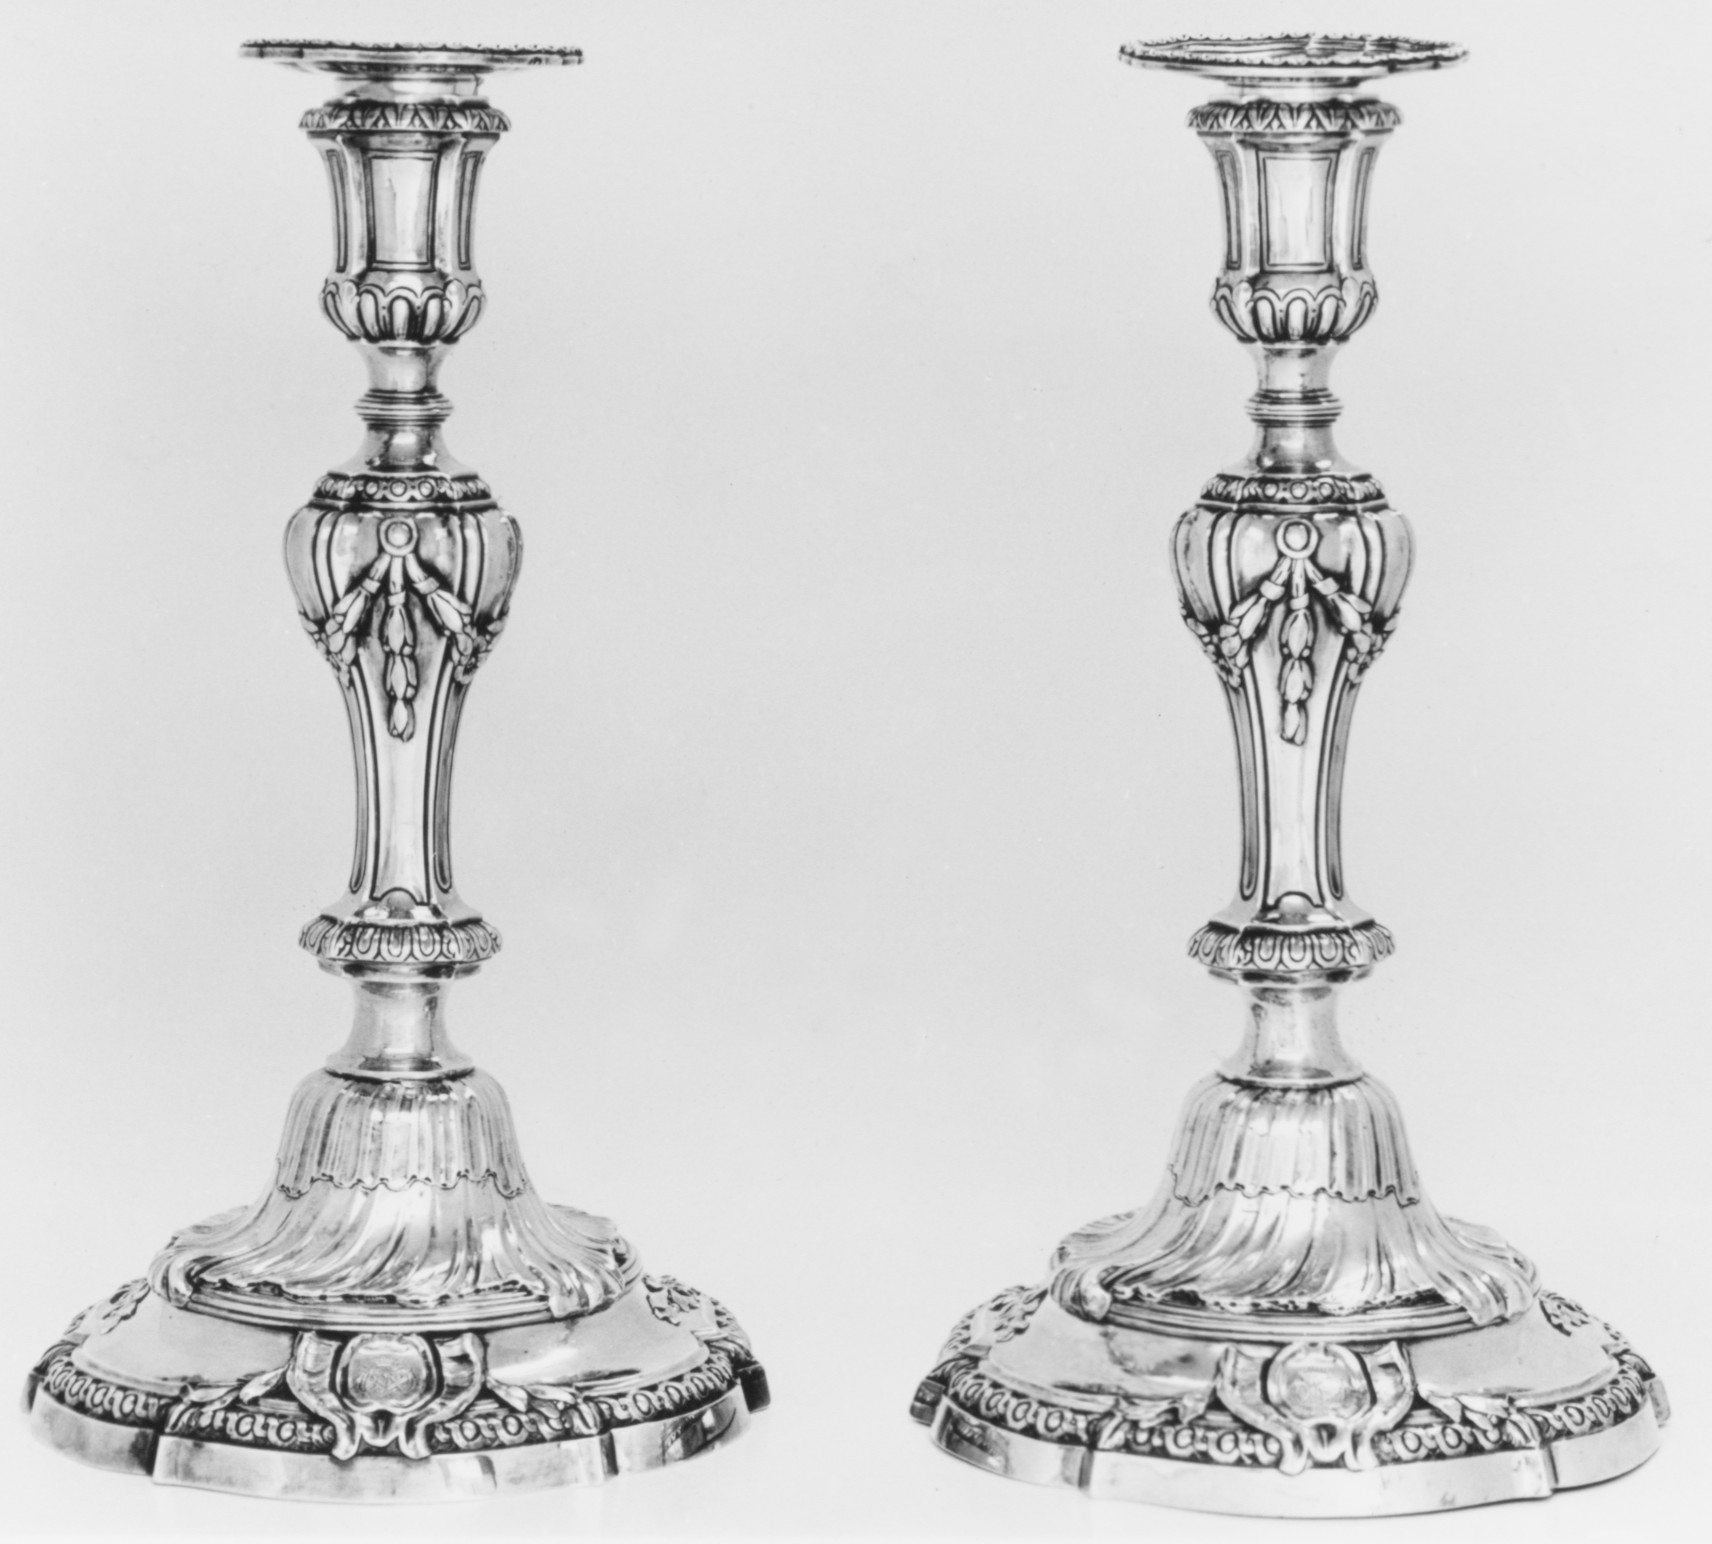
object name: candlestick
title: Pair of candlesticks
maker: jean-baptiste-françois chéret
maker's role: maker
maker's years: 1728-1791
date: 1767-1768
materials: silver